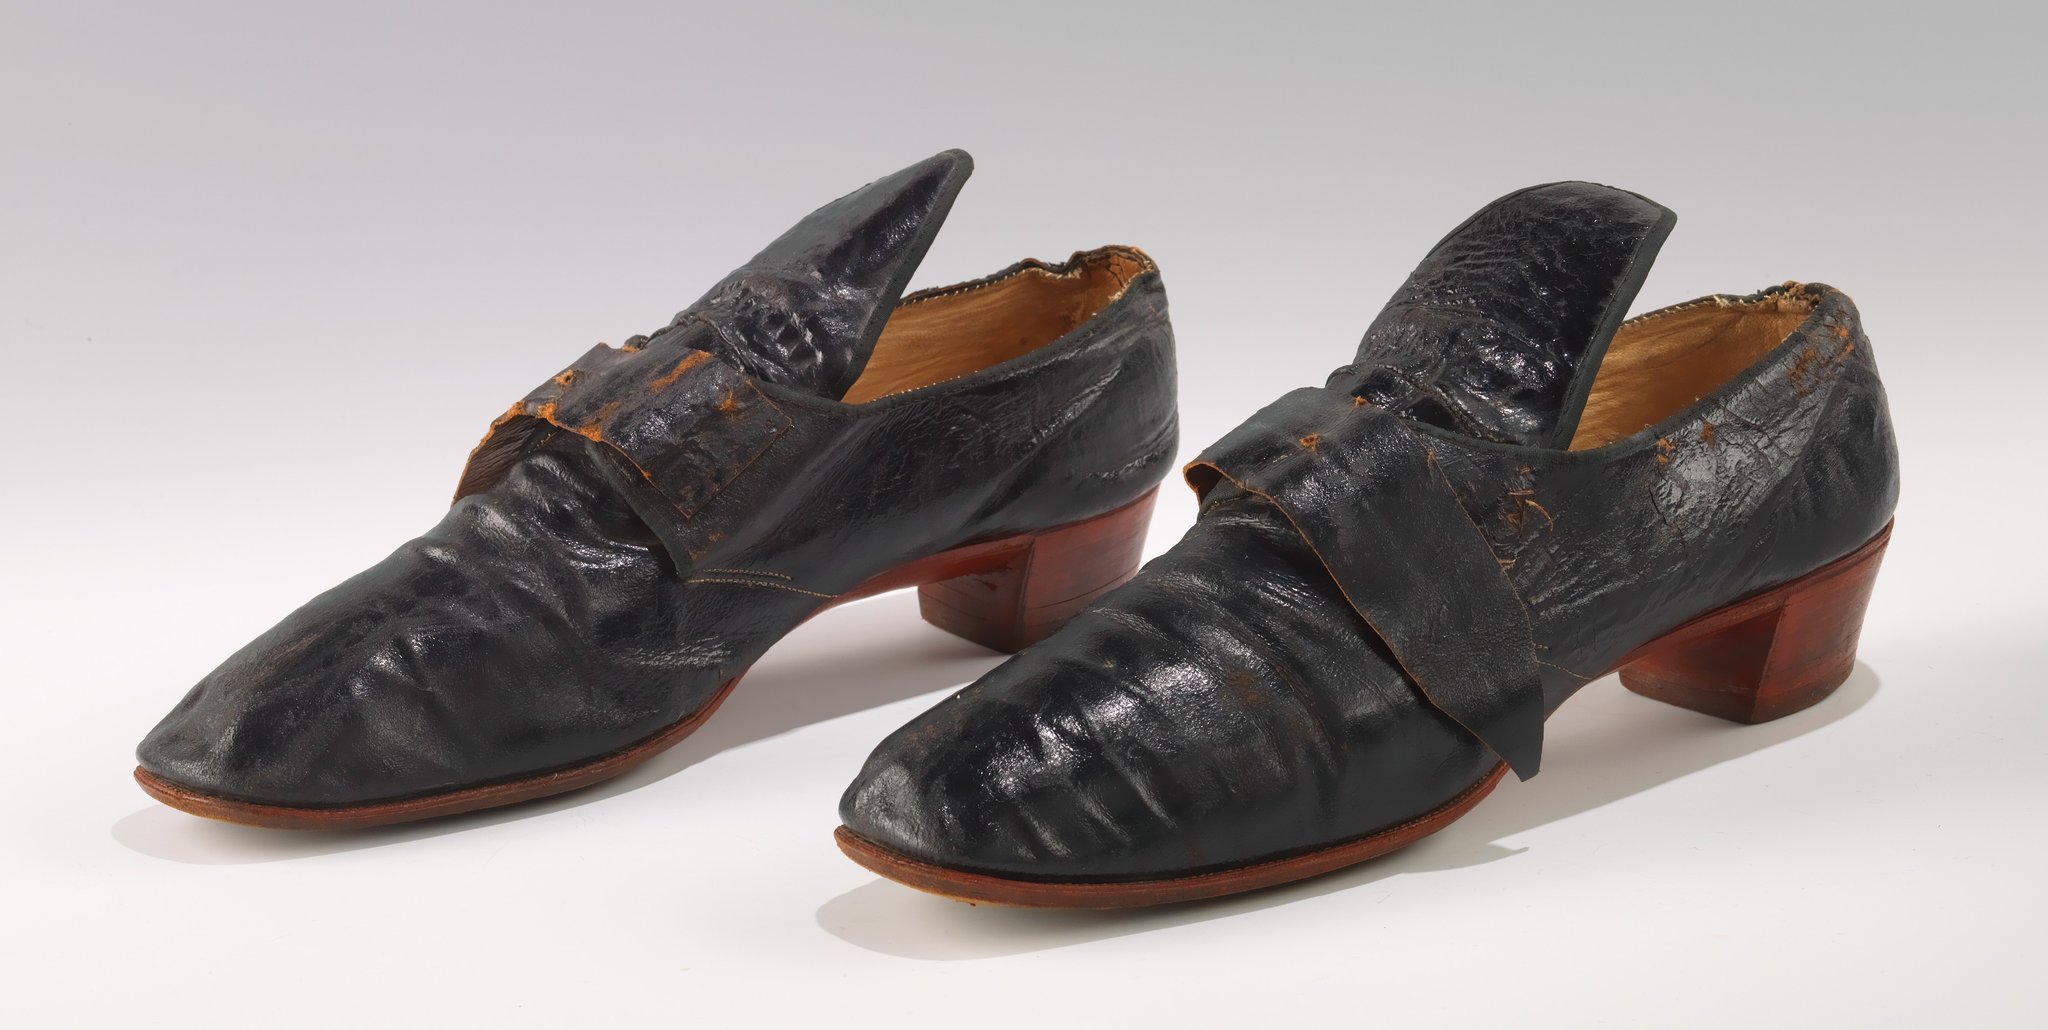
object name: court shoe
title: Court shoes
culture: french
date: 1780-1800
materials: hair, leather, linen, metal, silk